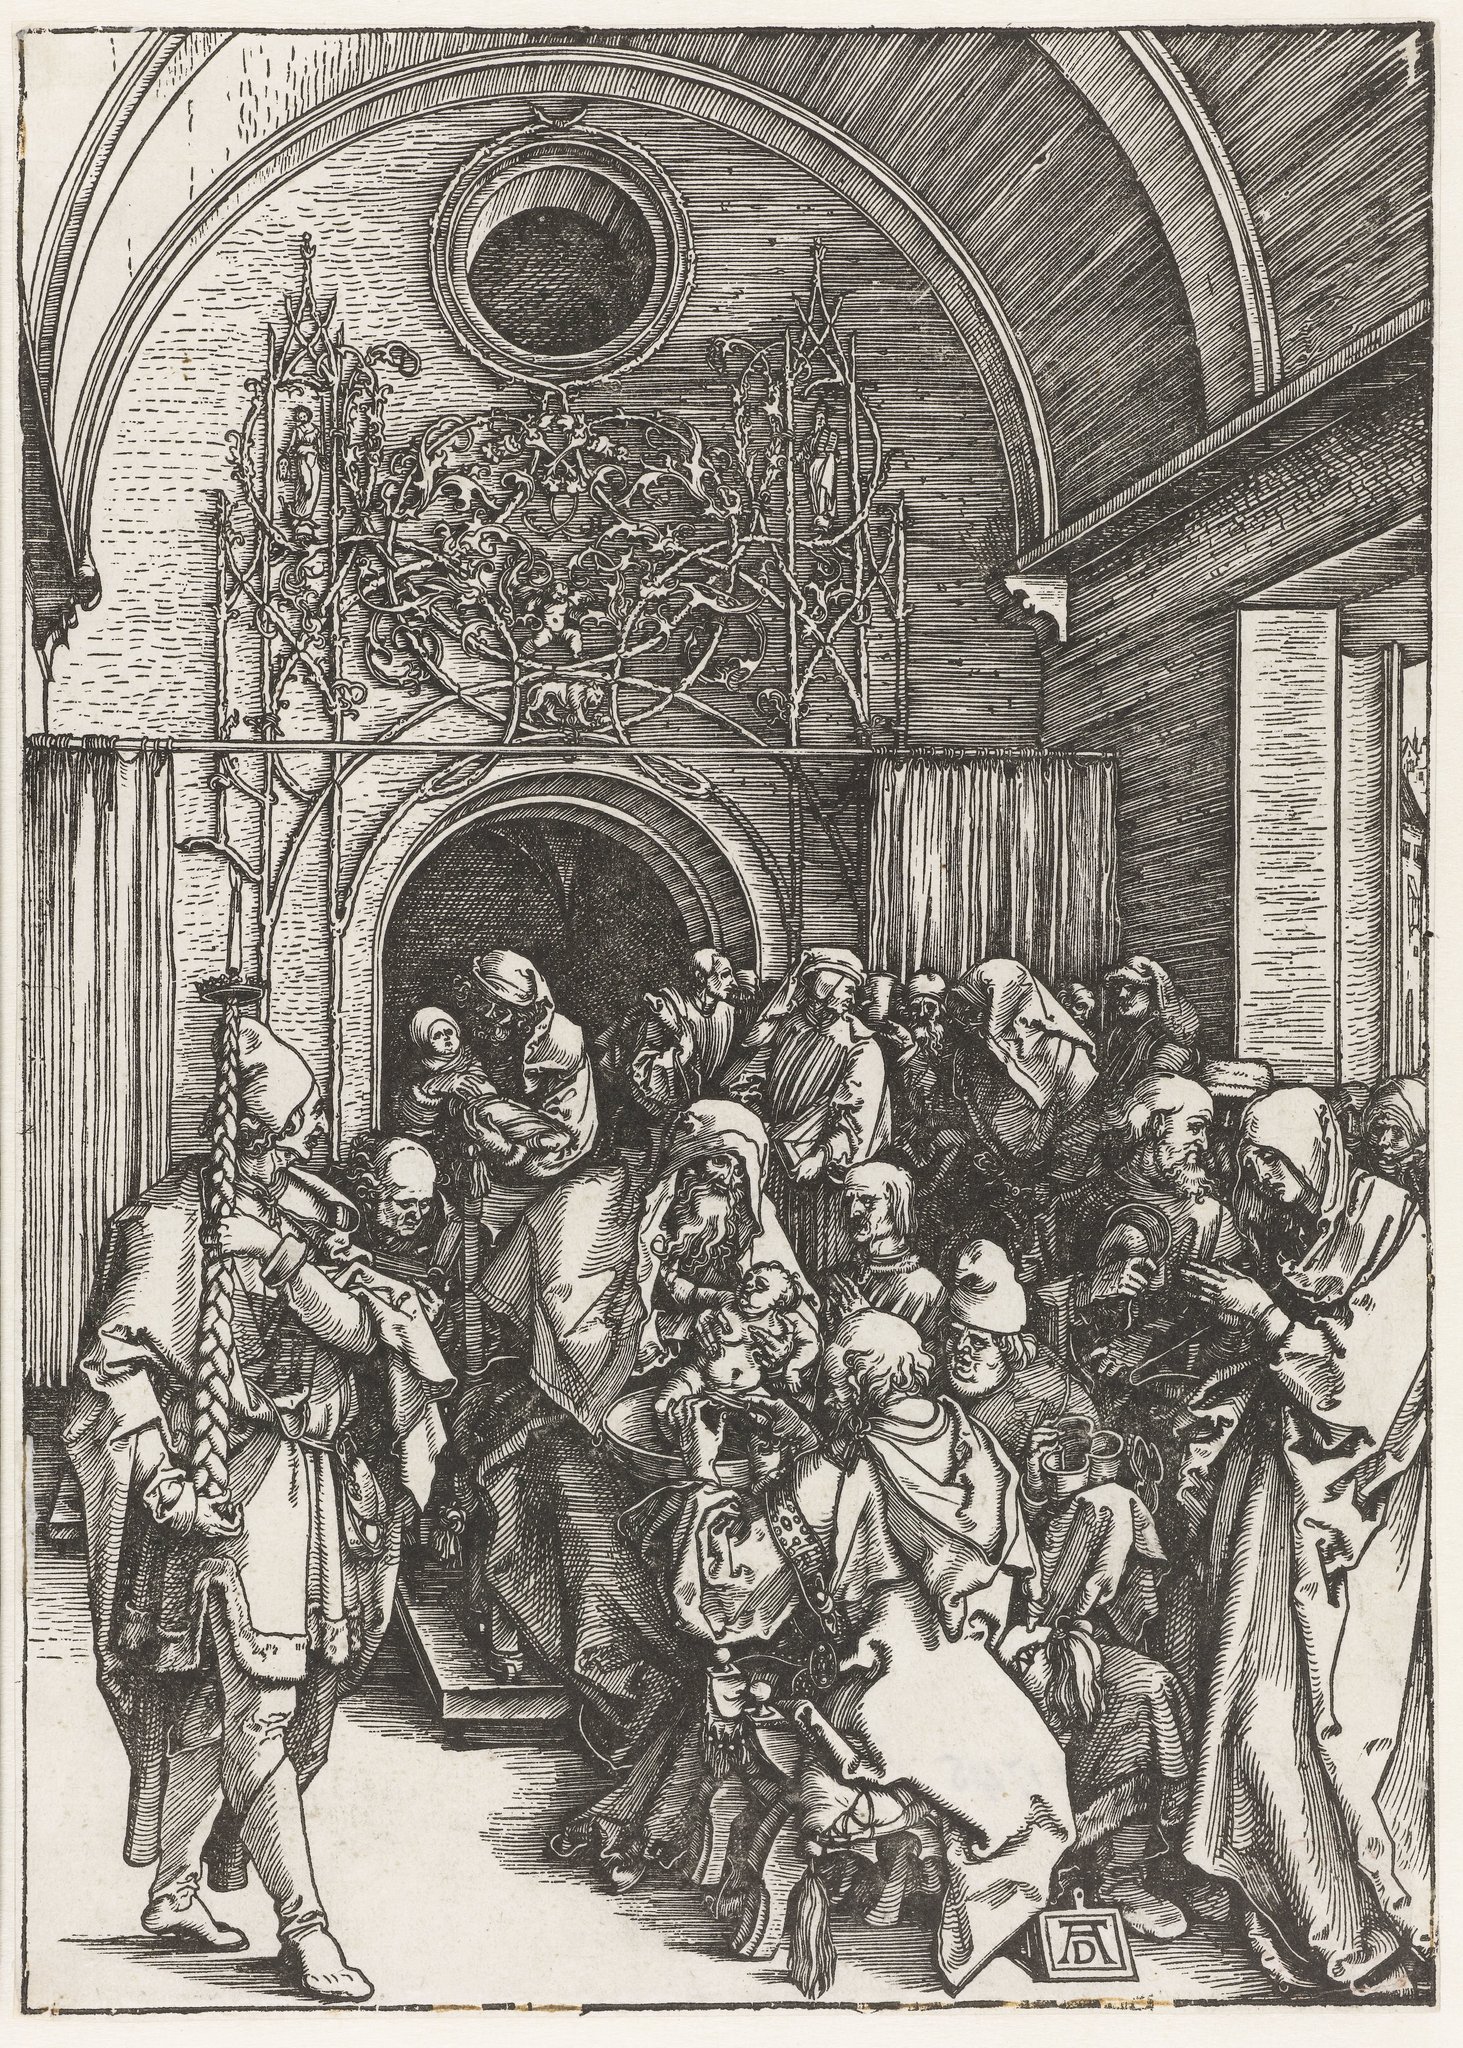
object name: print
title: Besnijdenis van Christus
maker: albrecht dürer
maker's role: draughtsman, painter, print maker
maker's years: 1471-1528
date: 1502-1506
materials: paper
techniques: woodcut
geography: nuremberg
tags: circumcision of the christ-child by the priest in the temple (luke 2:21)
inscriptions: collector's mark: Lugt 240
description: In een tempelruimte wordt het Christuskind besneden, in aanwezigheid van een groep mannen en vrouwen. Deze prent is onderdeel van een serie van 20 prenten, bestaand uit een titelprent en 19 prenten met scènes uit het leven van Maria.